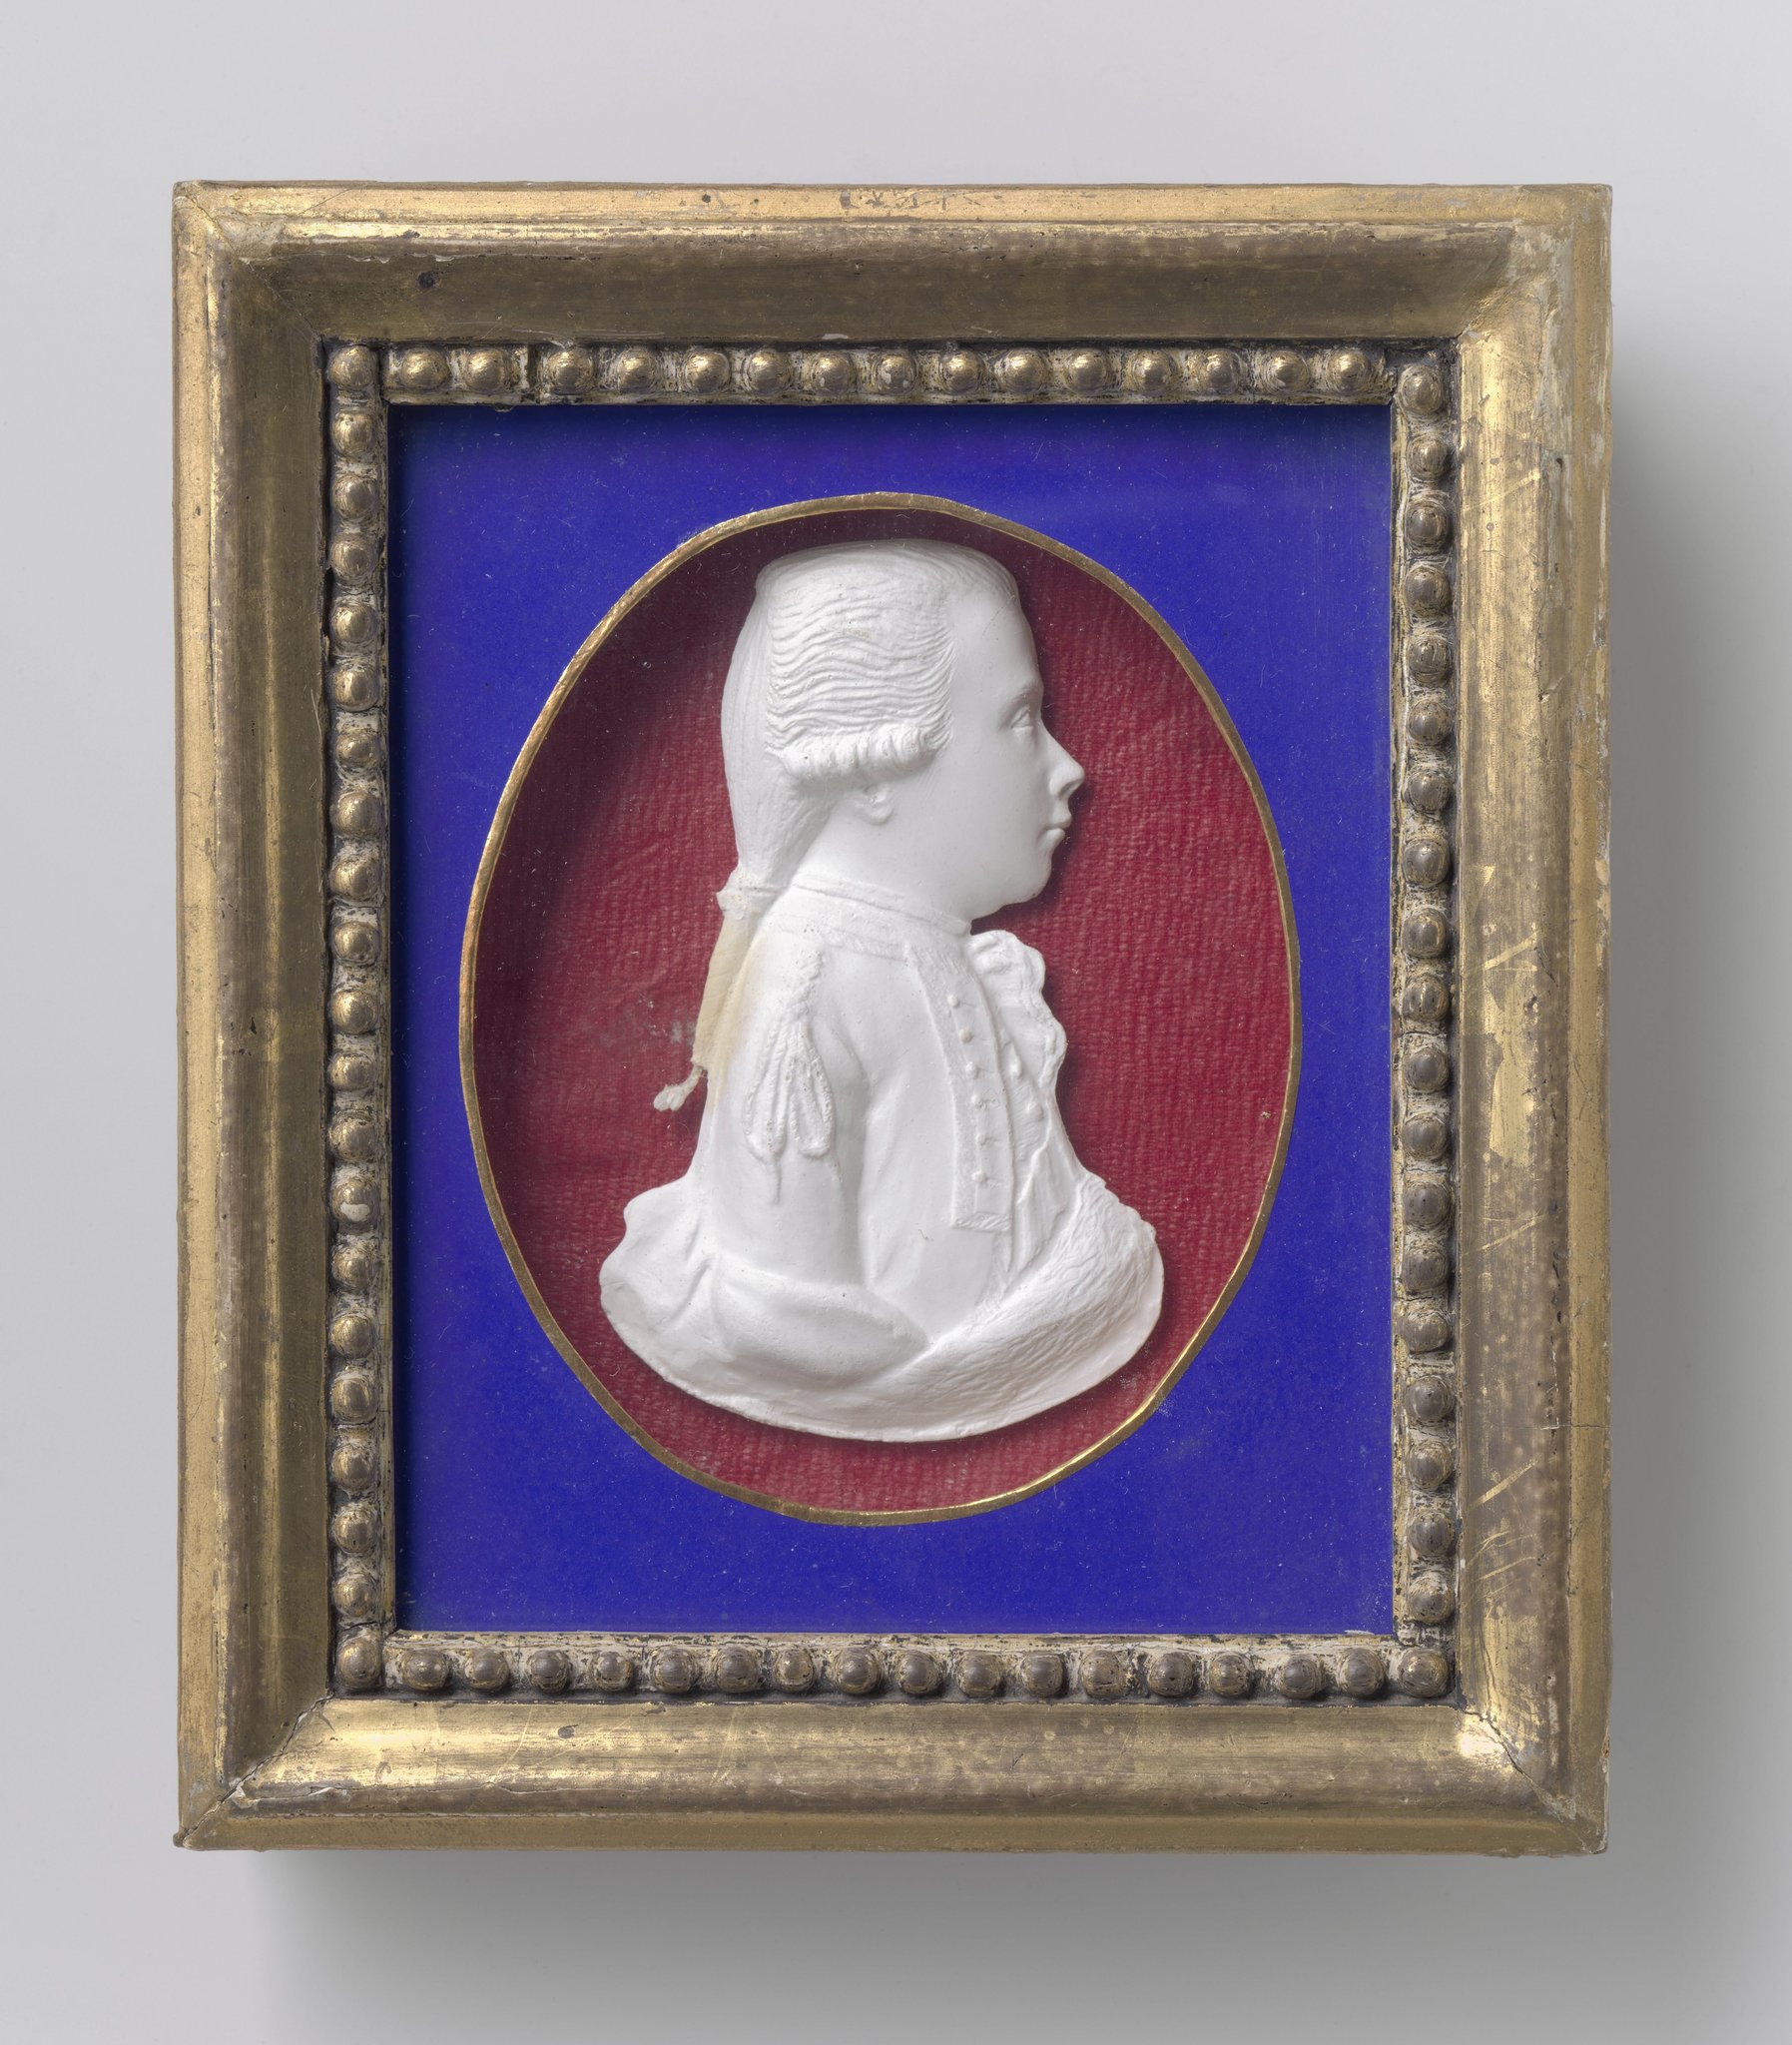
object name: portretmedaillon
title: Portretmedaillon van Prins Frederik Willem George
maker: johann heinrich schepp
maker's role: sculptor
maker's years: 1736-1811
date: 1784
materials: gypsum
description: Portretmedaillon van Prins Frederik Willem George. De prins is naar rechts gewend. Hij draagt een staartpruik, een uniformjas met op de schouders nestels, ordelint en jabot. Om zijn middel is een mantel gedrapeerd.